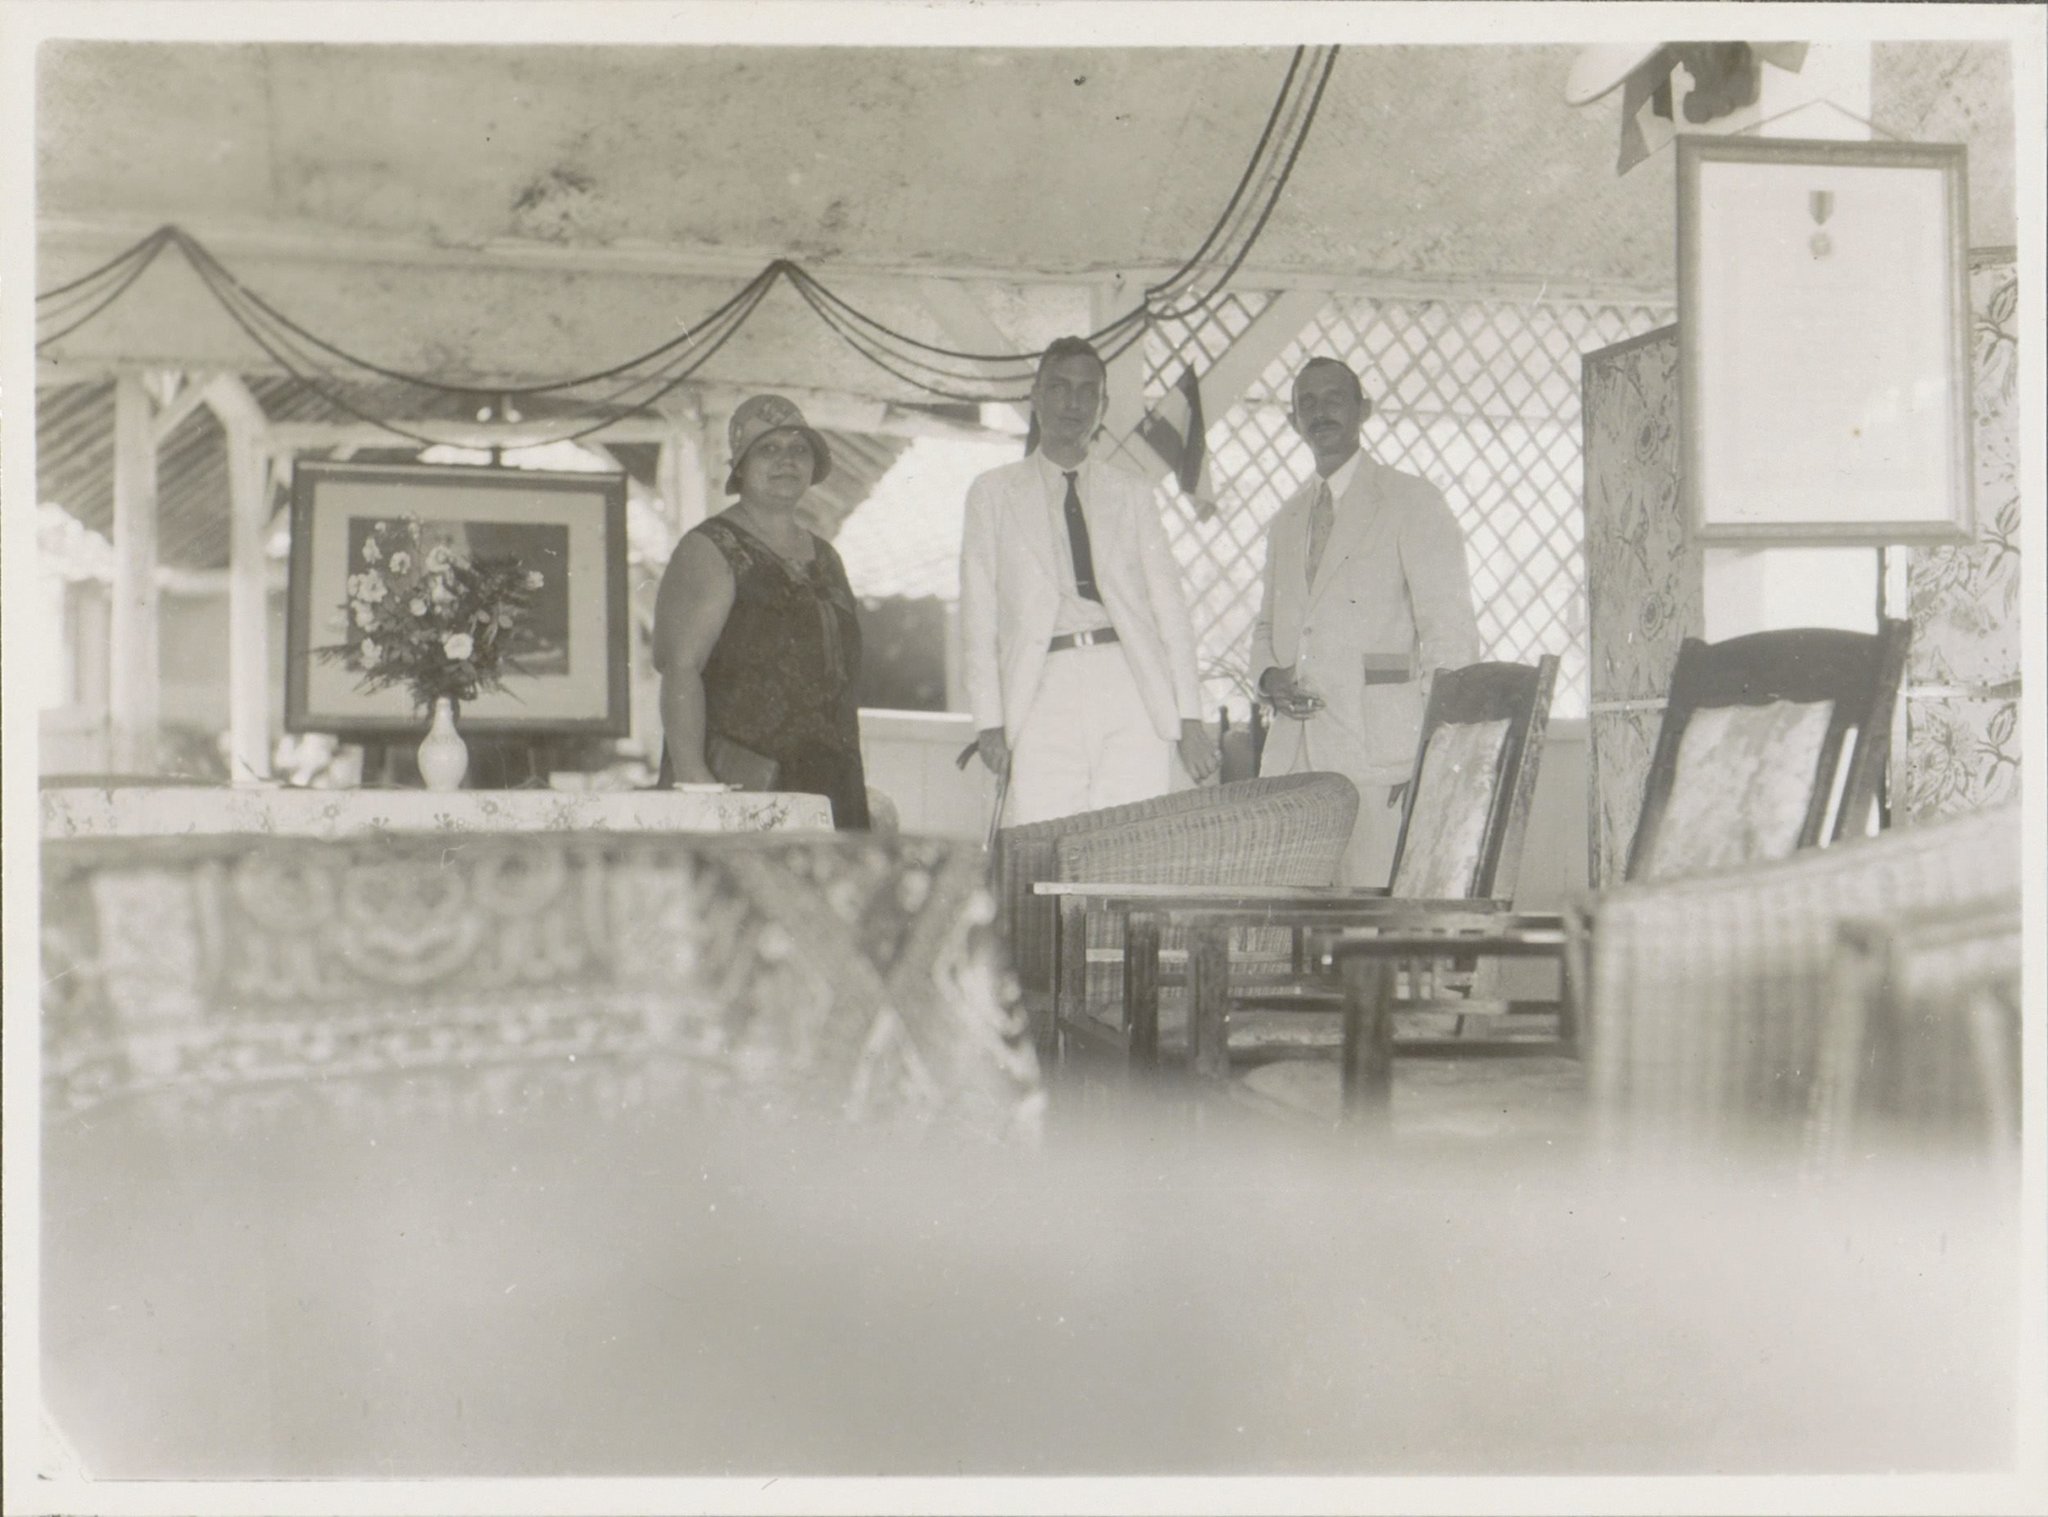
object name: photograph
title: De hartelijke ontvangst i/d feestelijk versierde pendopo v/d Ass: Wedono. Mr.C.W.A. Abbenhuis met den Leider der Kolonisatie en Mevr: Barkmeijer.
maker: Anonymous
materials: photographic support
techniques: gelatin silver print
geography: dutch east indies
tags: official; civil servant; functionary (in general), reception, cocktail party, dutch east indies, the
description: Op de foto links mevrouw Barkmeijer, in het midden C.W.A. Abbenhuis, naam man rechts onbekend. Onderdeel van Fotoalbum aangeboden aan de resident der Lampongse districten F.J. Junius door studerende ambtenaren van de bestuursschool te Batavia.